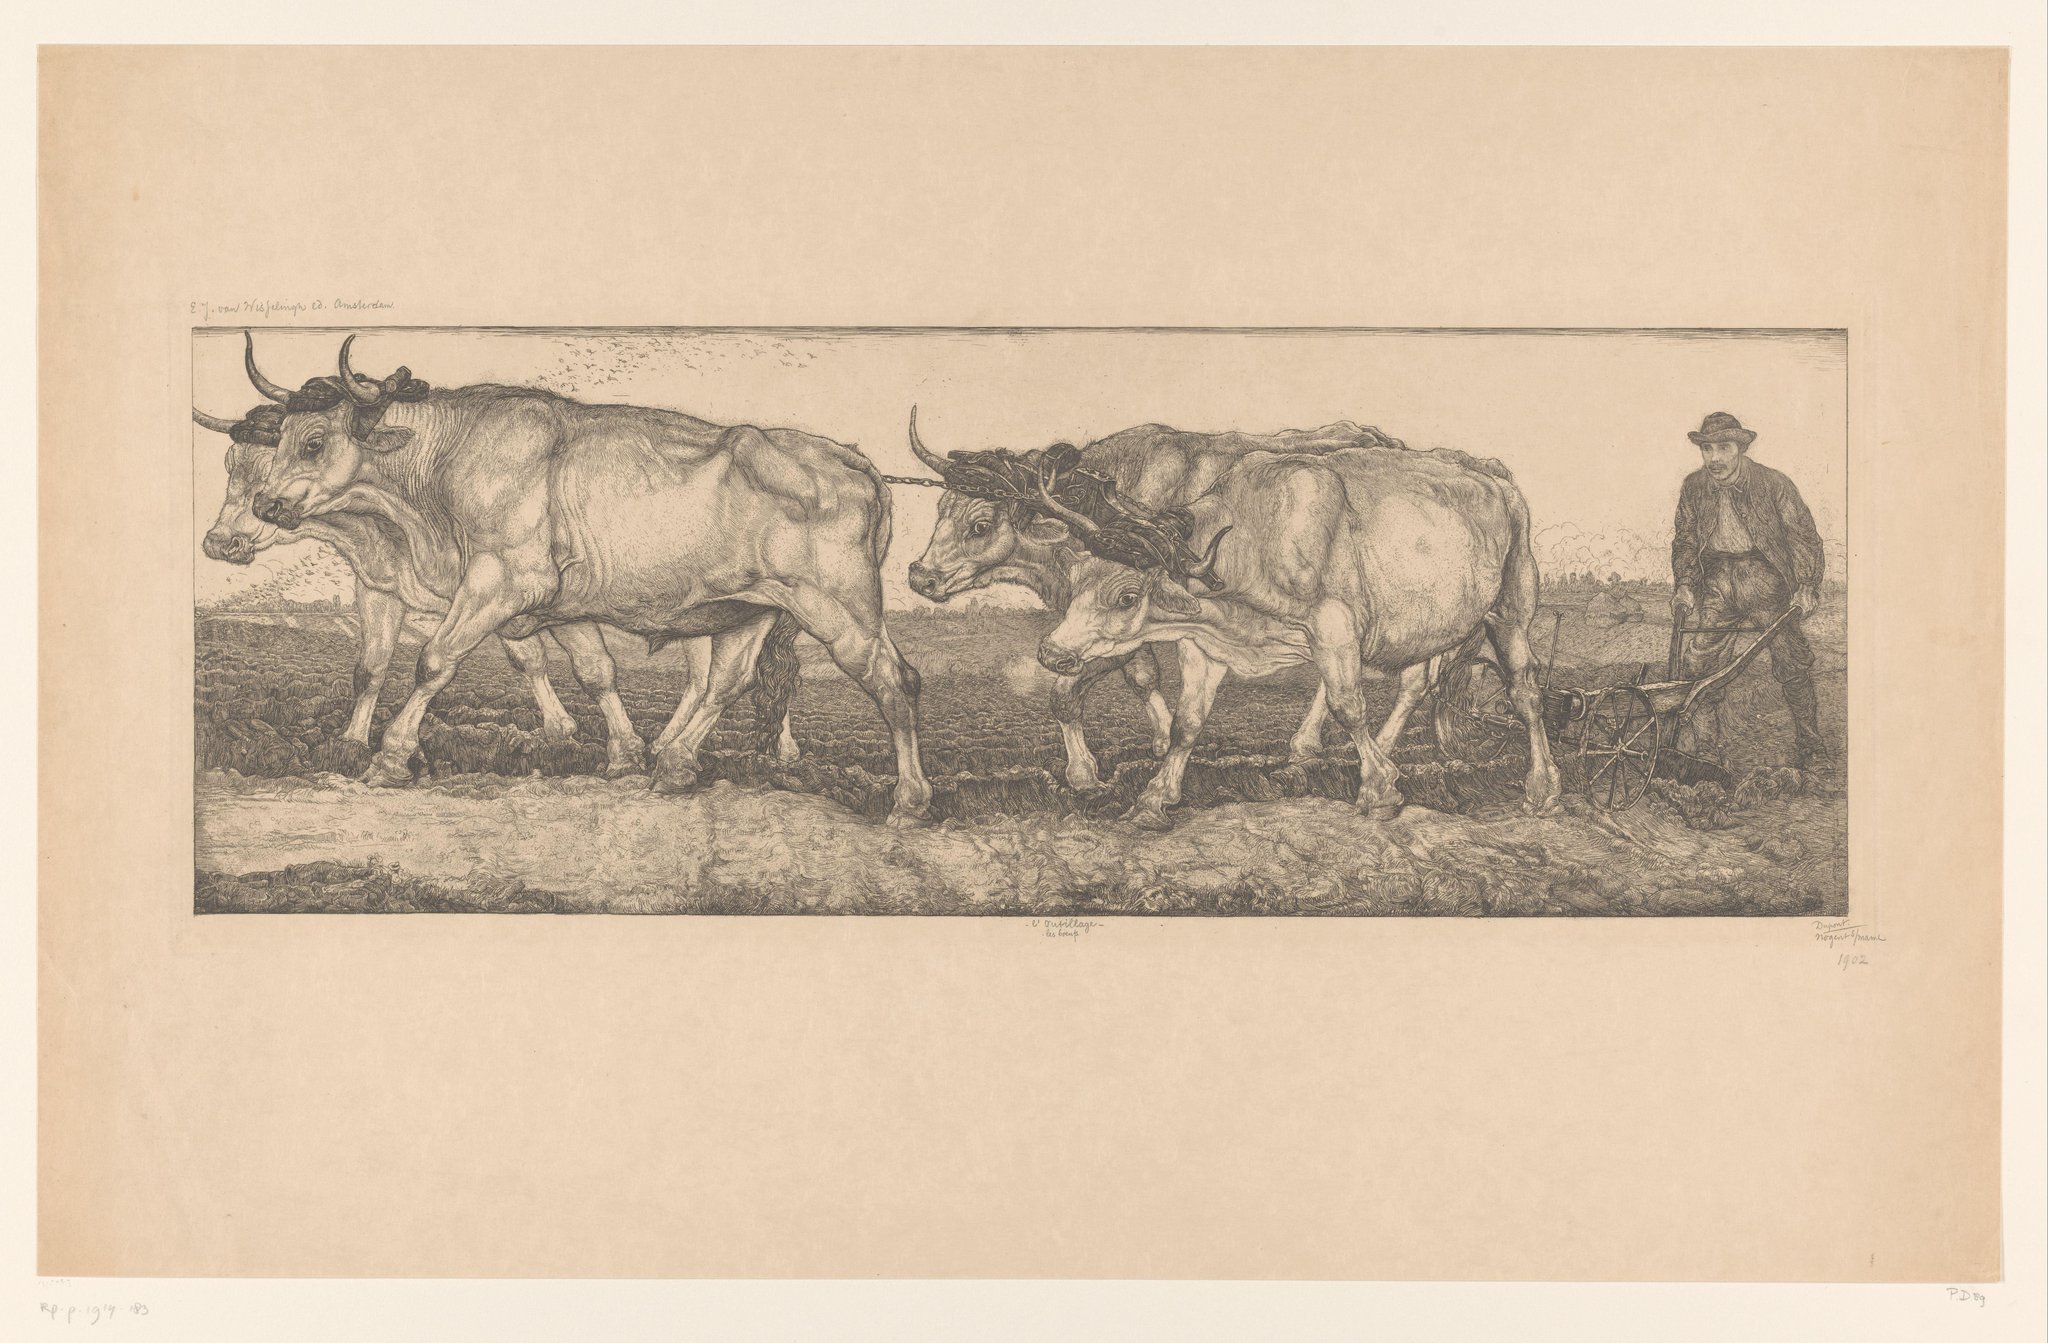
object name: print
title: L'Outillage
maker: pieter dupont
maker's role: draughtsman, print maker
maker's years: 1870-1911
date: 1902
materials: paper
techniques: etching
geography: amsterdam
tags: bull, ploughing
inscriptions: collector's mark: Lugt 2228, collector's mark: Lugt 2233